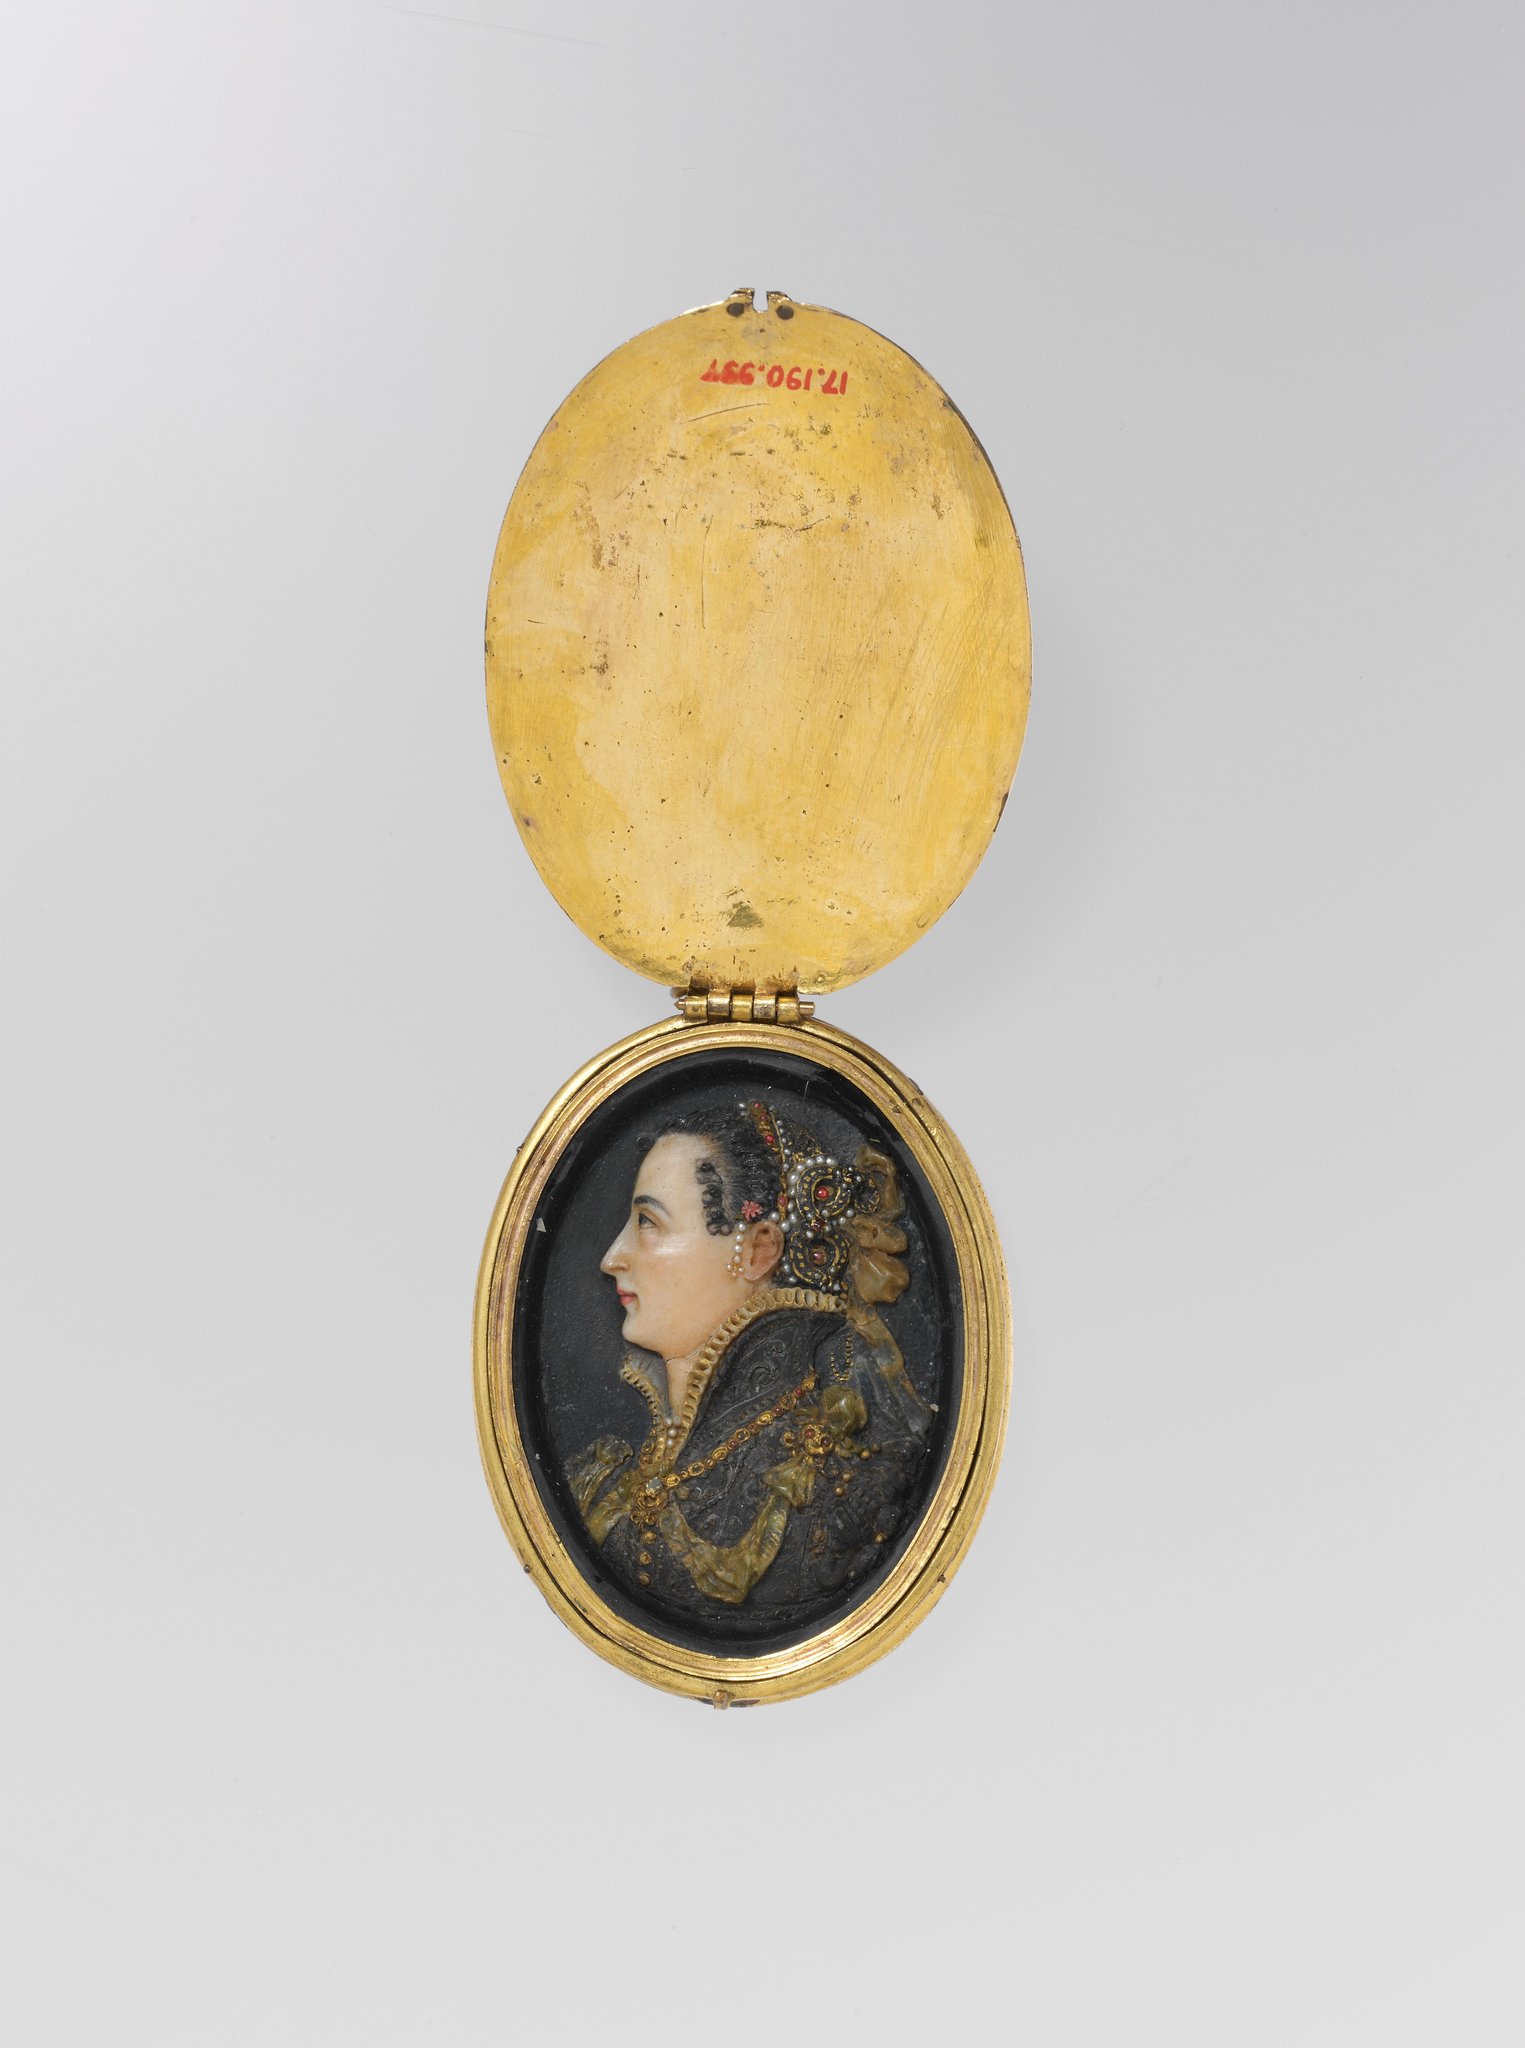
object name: sculpture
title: A lady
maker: alfred andré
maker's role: maker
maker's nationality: french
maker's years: 1839-1919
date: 1867-1900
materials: copper gilt, wax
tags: profiles,women